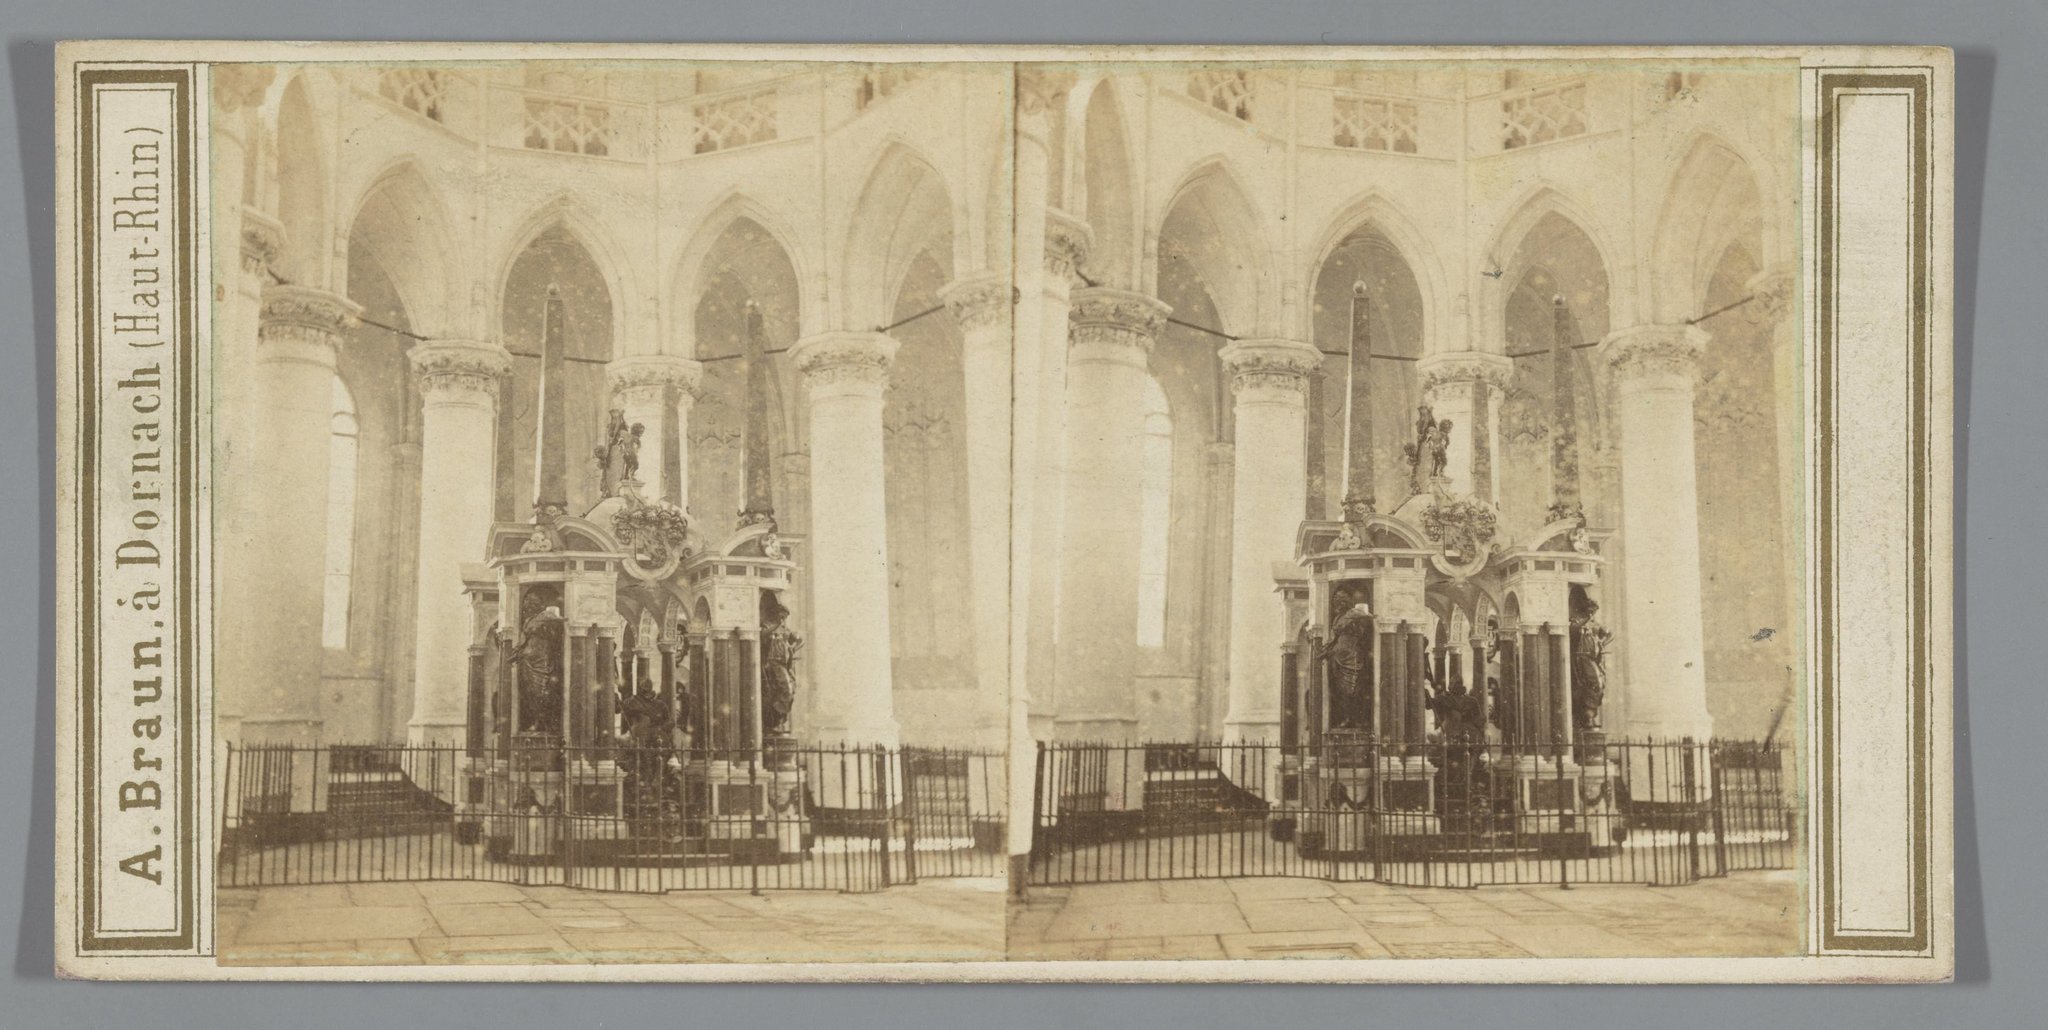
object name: stereograph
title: Delft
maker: Anonymous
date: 1860-1866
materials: cardboard, paper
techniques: albumen print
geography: nieuwe kerk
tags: grave, tomb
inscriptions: number: ‘No 3837.’